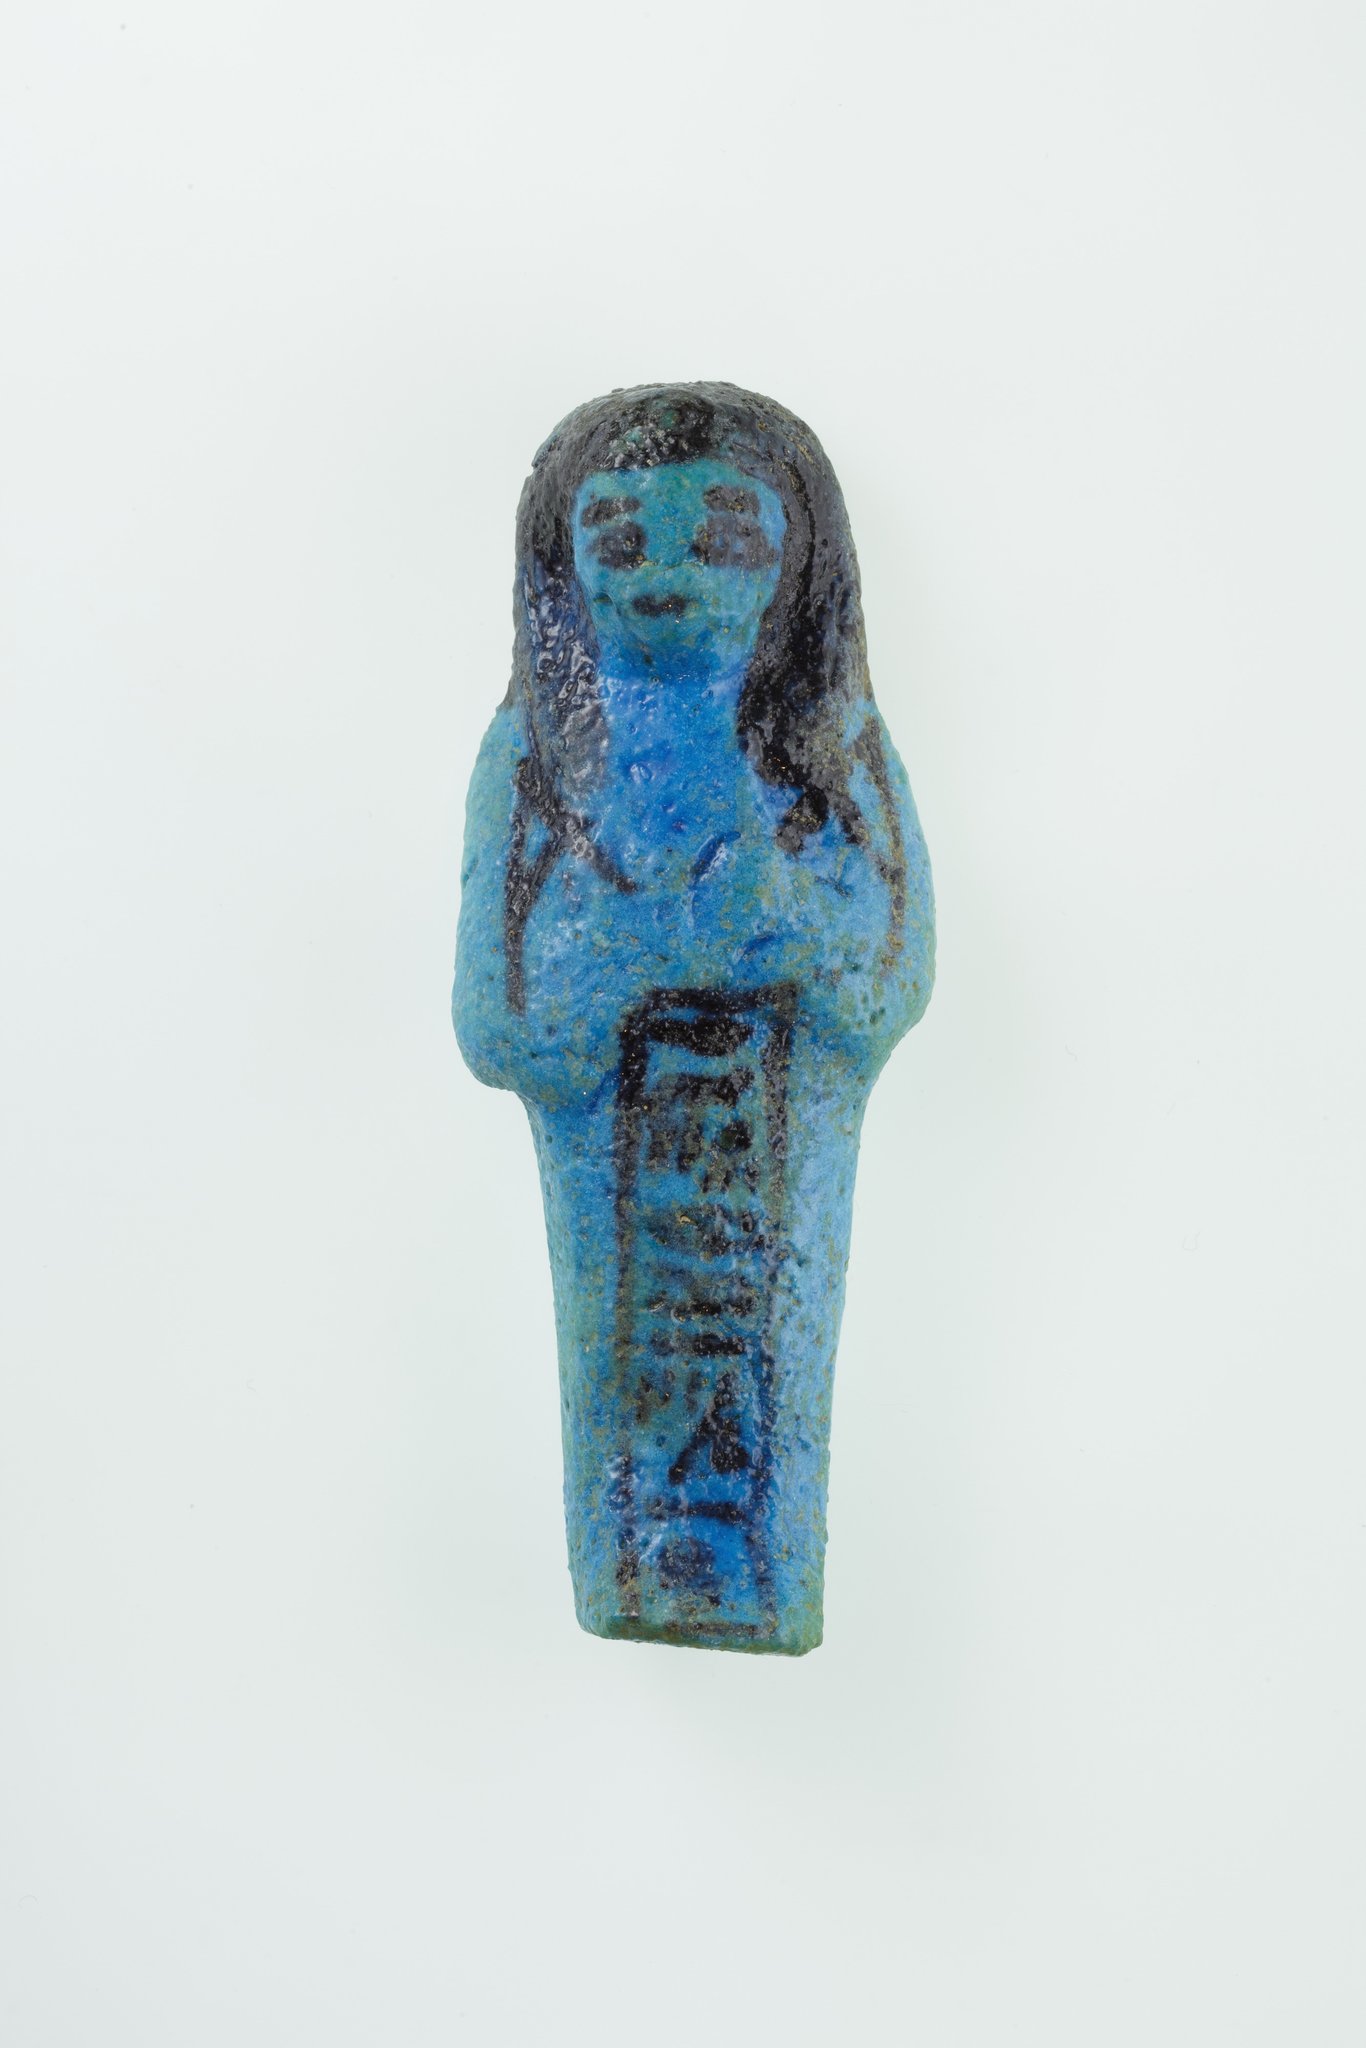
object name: shabti, worker, nauny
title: Worker Shabti of Nauny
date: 1050 BCE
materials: faience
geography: egypt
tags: hieroglyphs